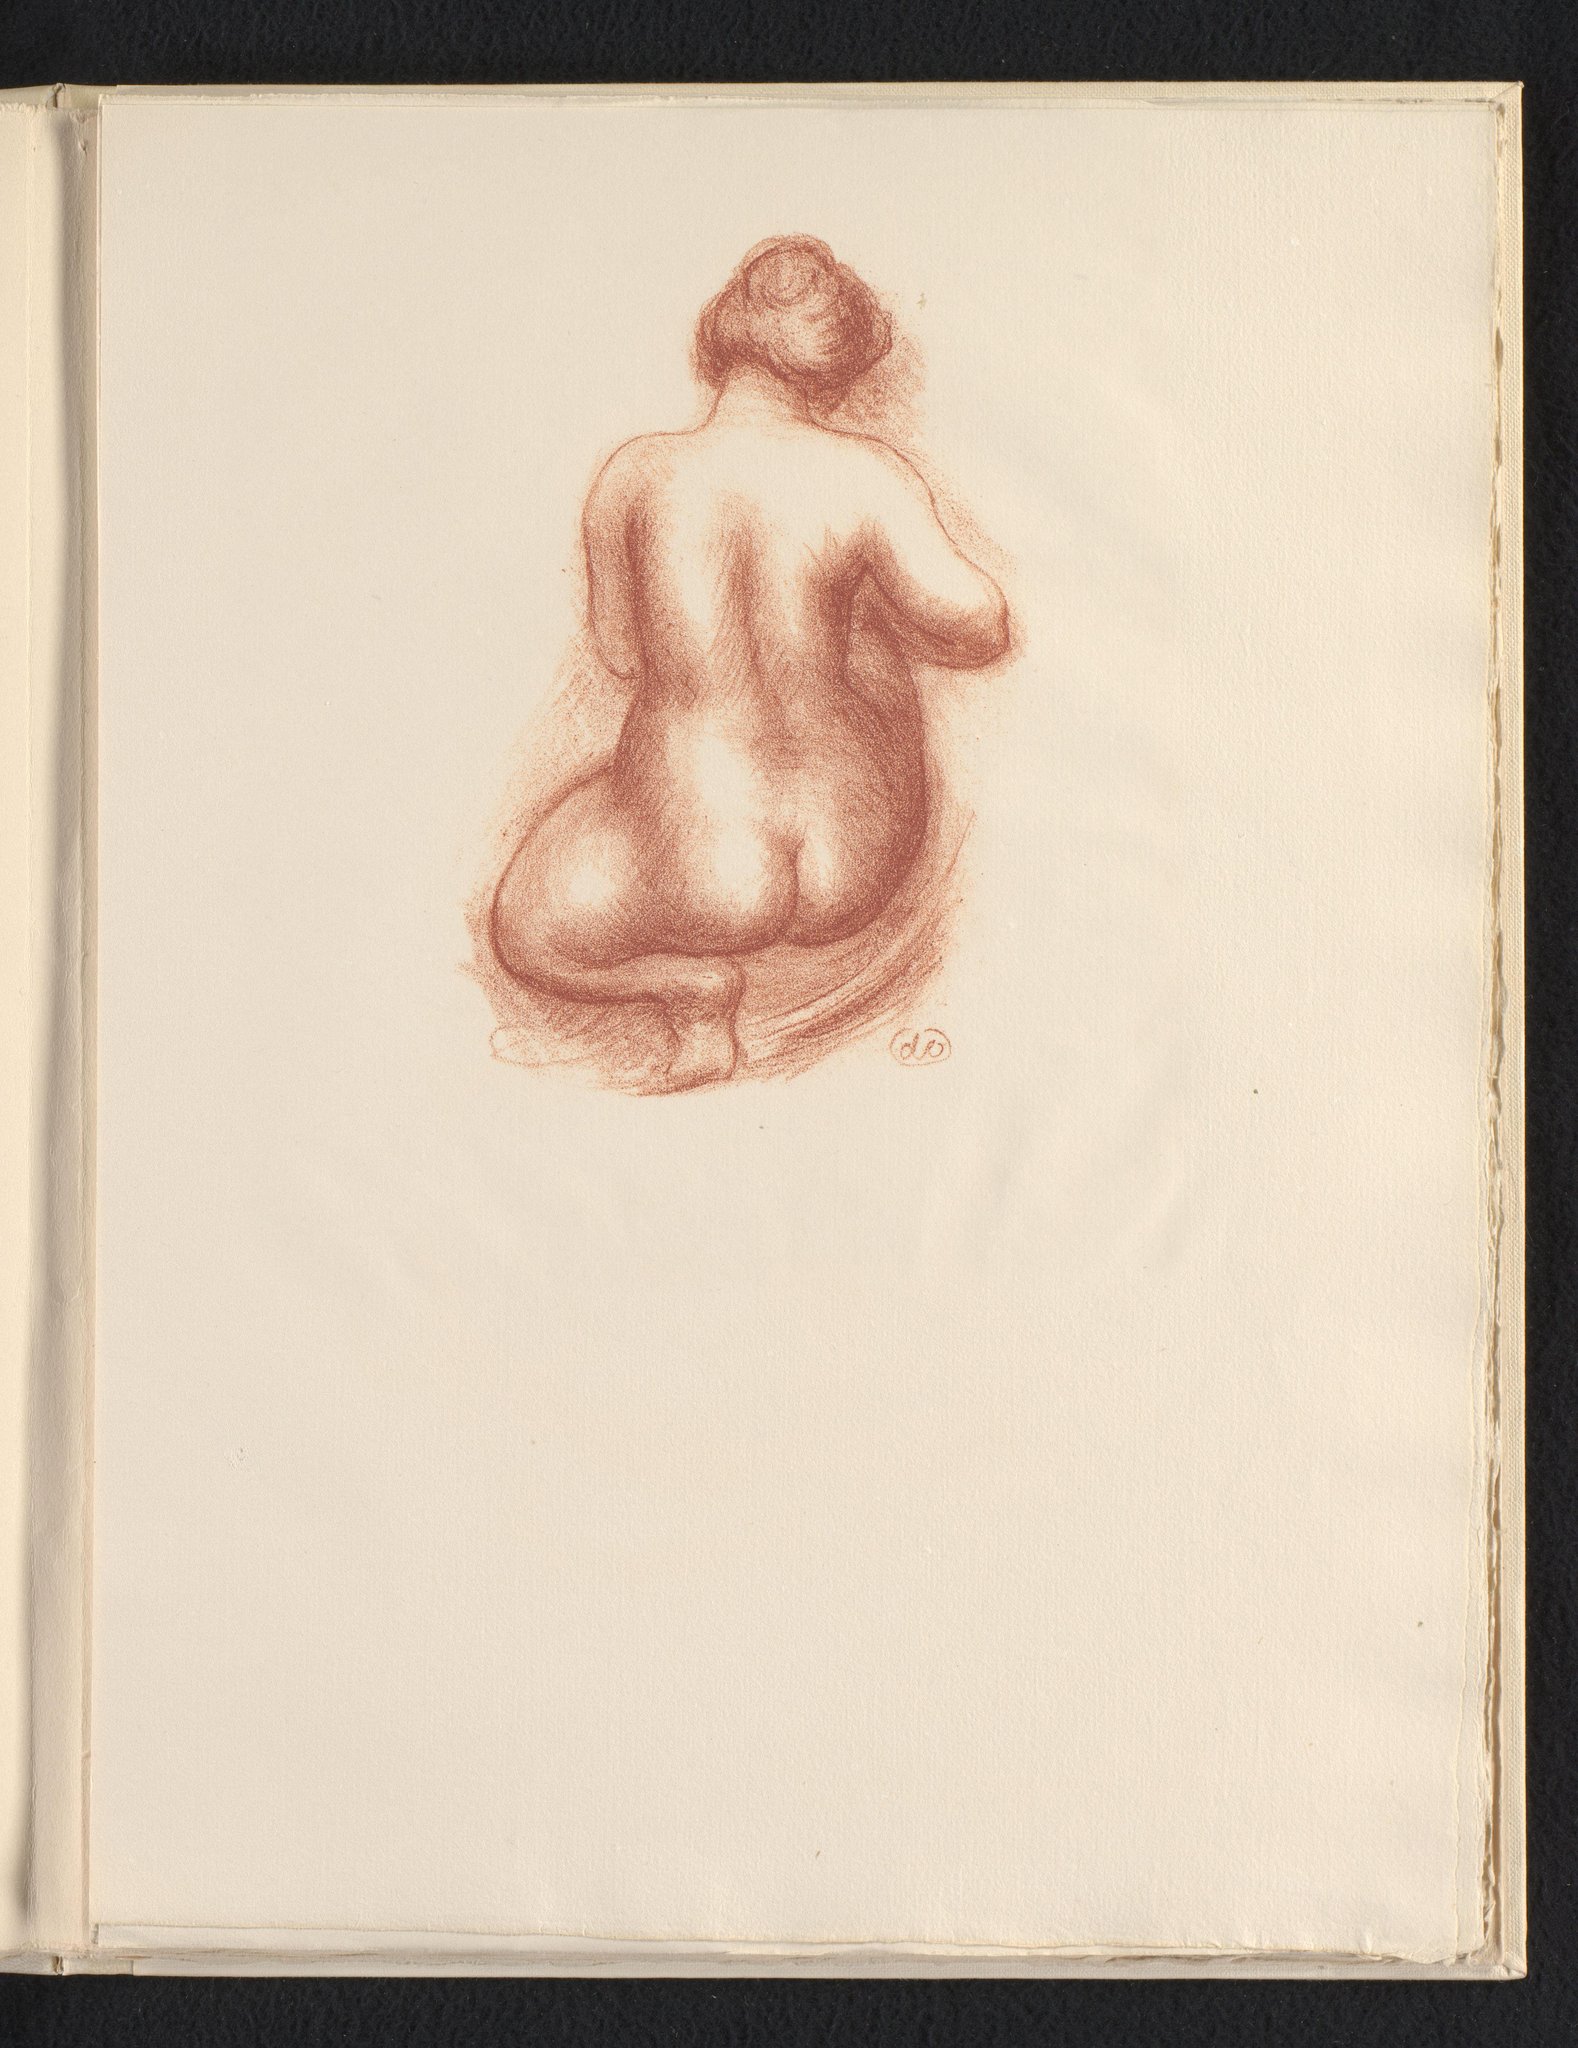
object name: print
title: Naakte vrouw, knielend op een been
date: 1948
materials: paper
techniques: lithograph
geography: paris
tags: kneeling figure - aa - female human figure, woman (showing herself) undressed, quasi-nude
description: Prent uit: Lucianus van Samosata. Dialogues des Courtisanes. [Vertaald uit het Grieks door] Charles Astruc. Parijs: s.n., 1948, deel van de suite met een extra afdruk van de prenten in sanguine.